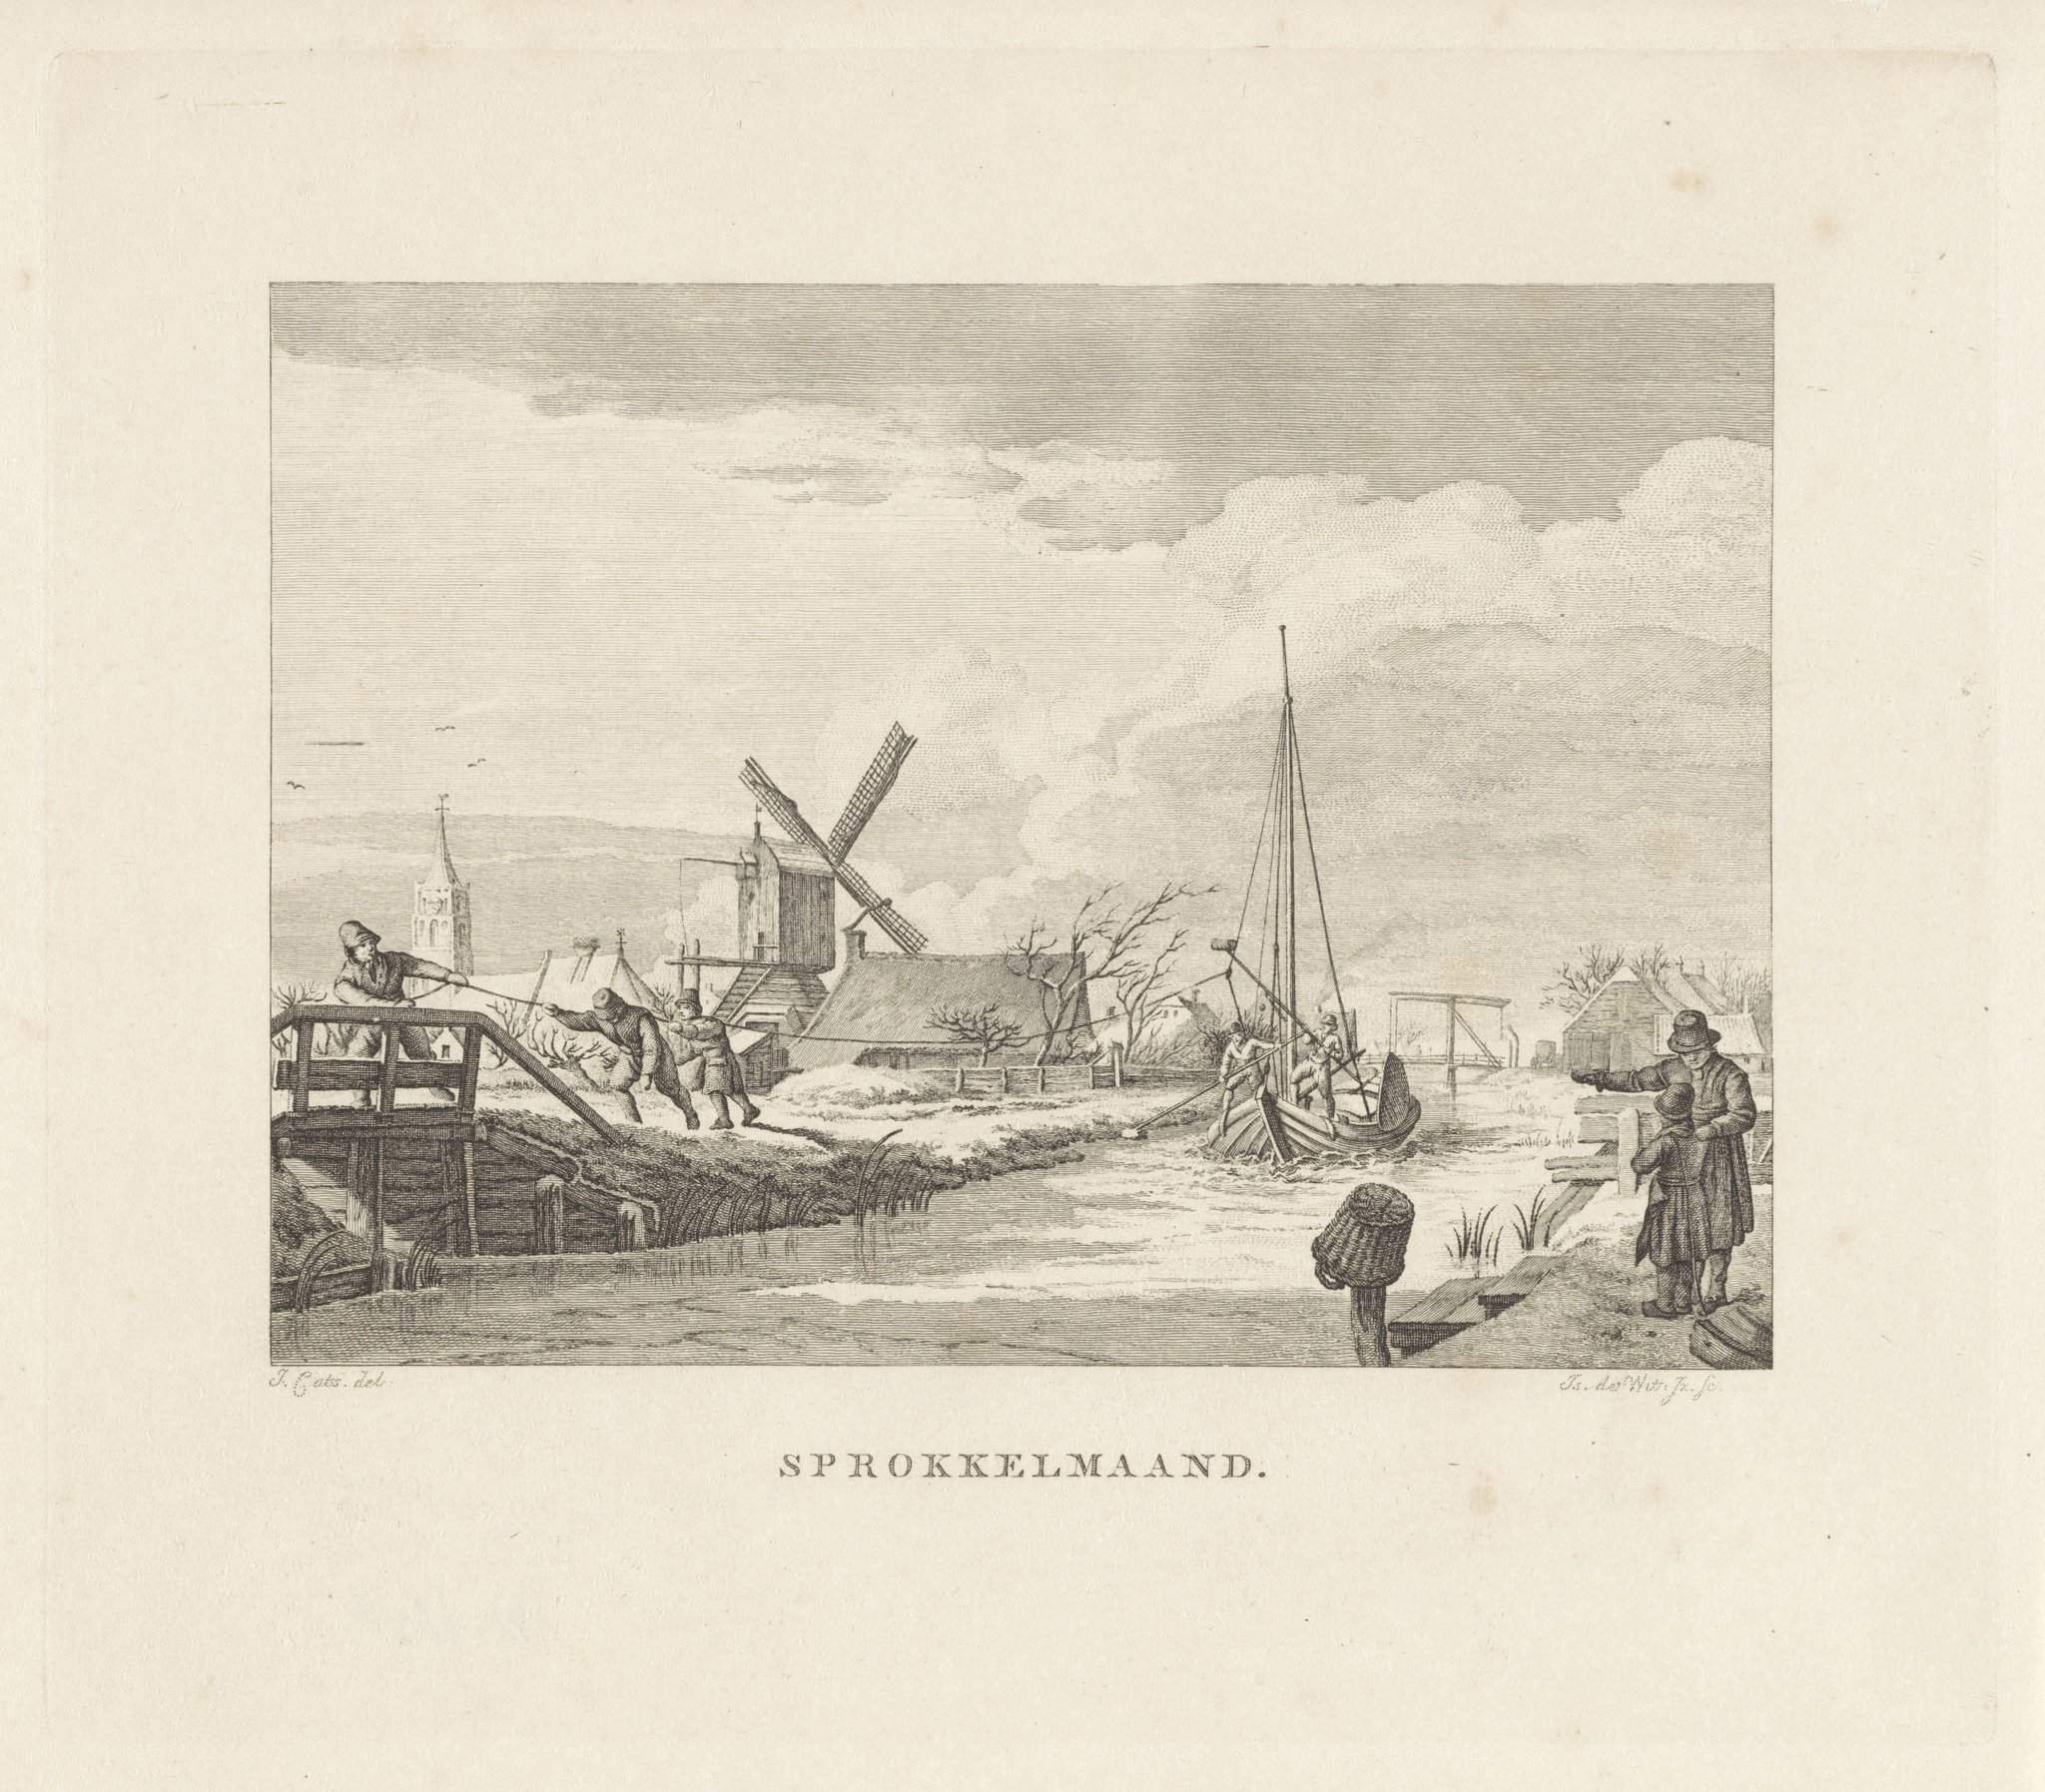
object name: print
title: Winterlandschap met een trekschuit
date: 1807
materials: paper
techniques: etching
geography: haarlem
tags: february and its 'labours' (+ with scenes showing human occupations ~ seasons and months), tow-boat, towing-barge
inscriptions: collector's mark: Lugt 2228